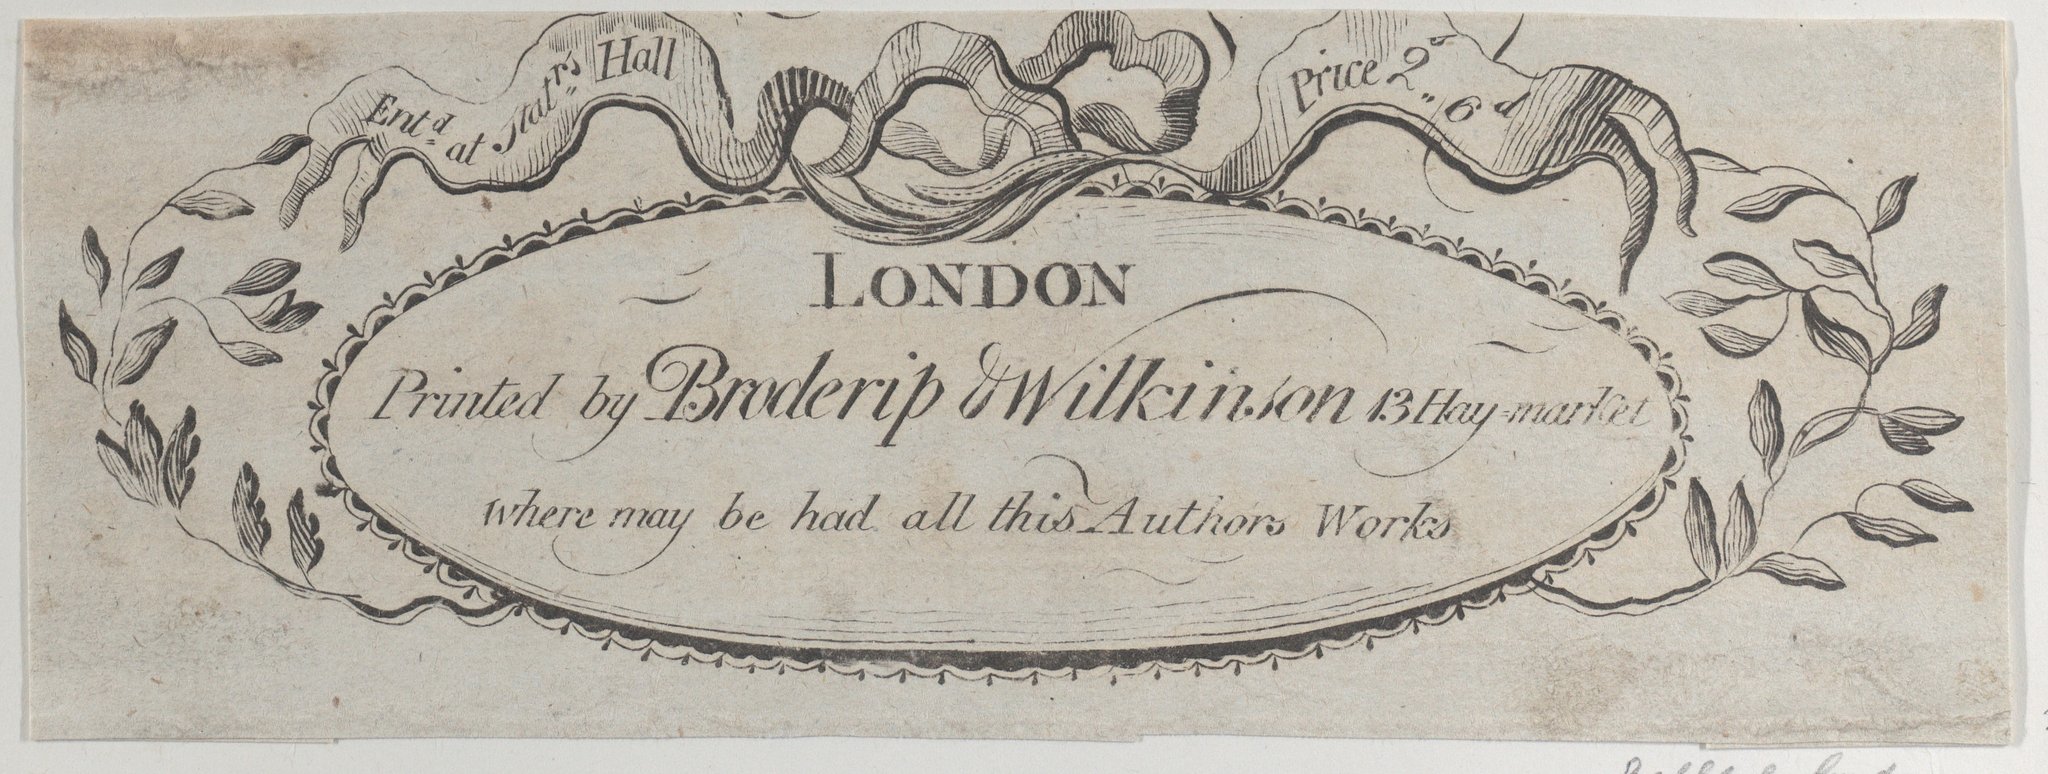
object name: print, trade card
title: Trade card for Broderip & Wilkinson, music sellers and musical instrument makers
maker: anonymous, british, 18th century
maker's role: artist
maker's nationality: british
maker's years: 1700-1800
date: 1701-1800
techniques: engraving